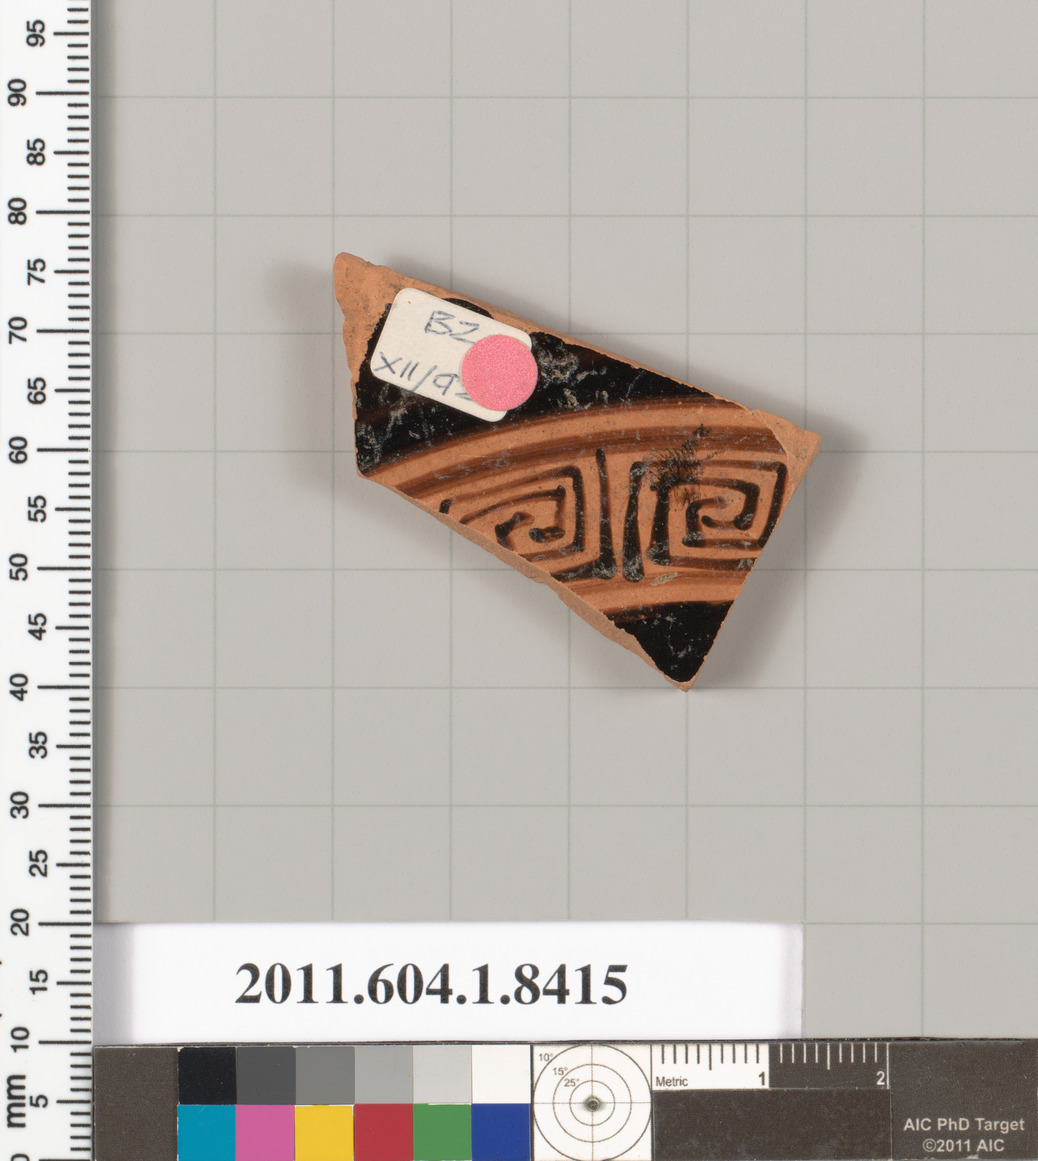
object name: kylix fragment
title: Terracotta fragment of a kylix (drinking cup)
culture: greek, attic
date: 375-351 BCE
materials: terracotta